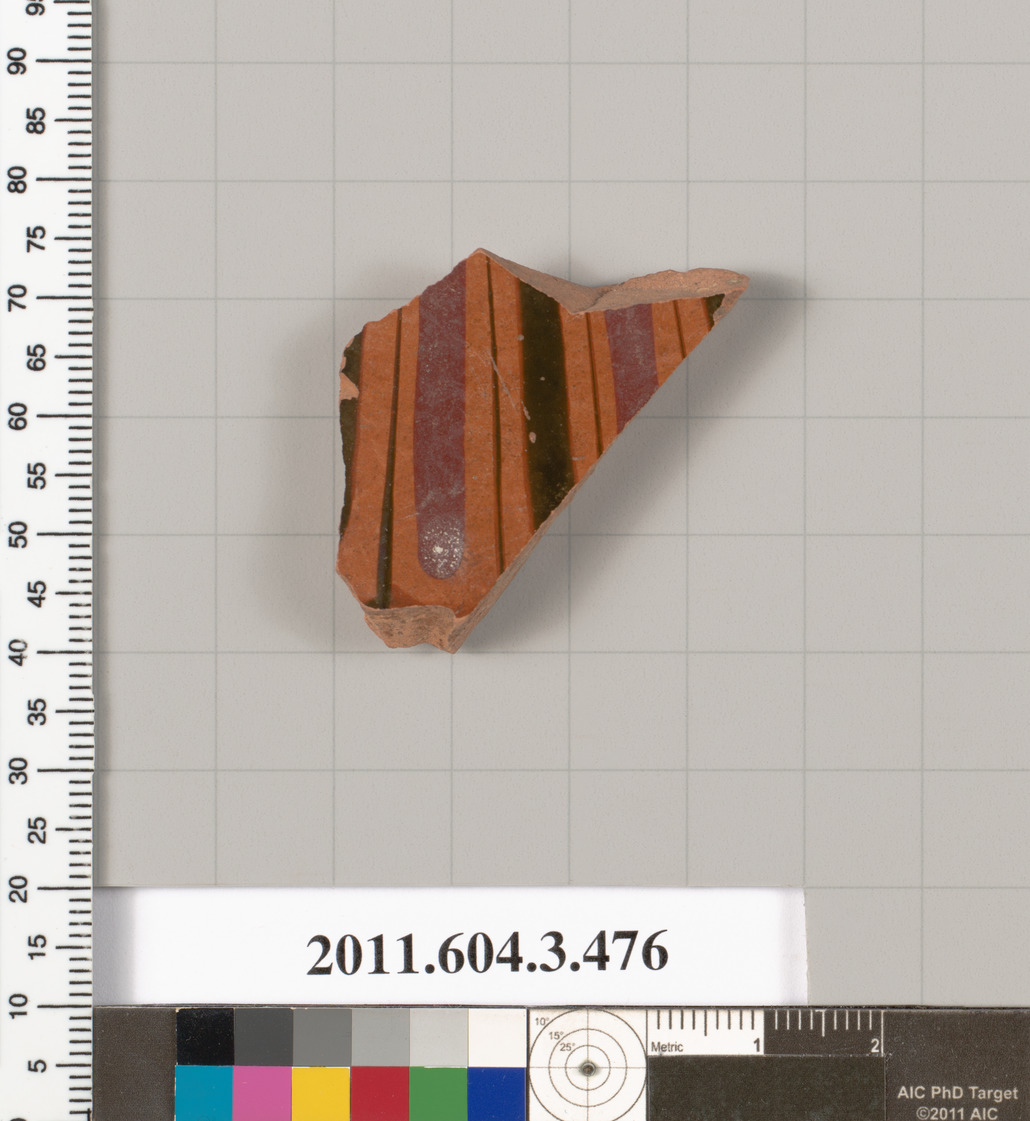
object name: panathenaic prize amphora fragment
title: Terracotta fragment of a Panathenaic prize amphora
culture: greek, attic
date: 525-501 BCE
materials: terracotta